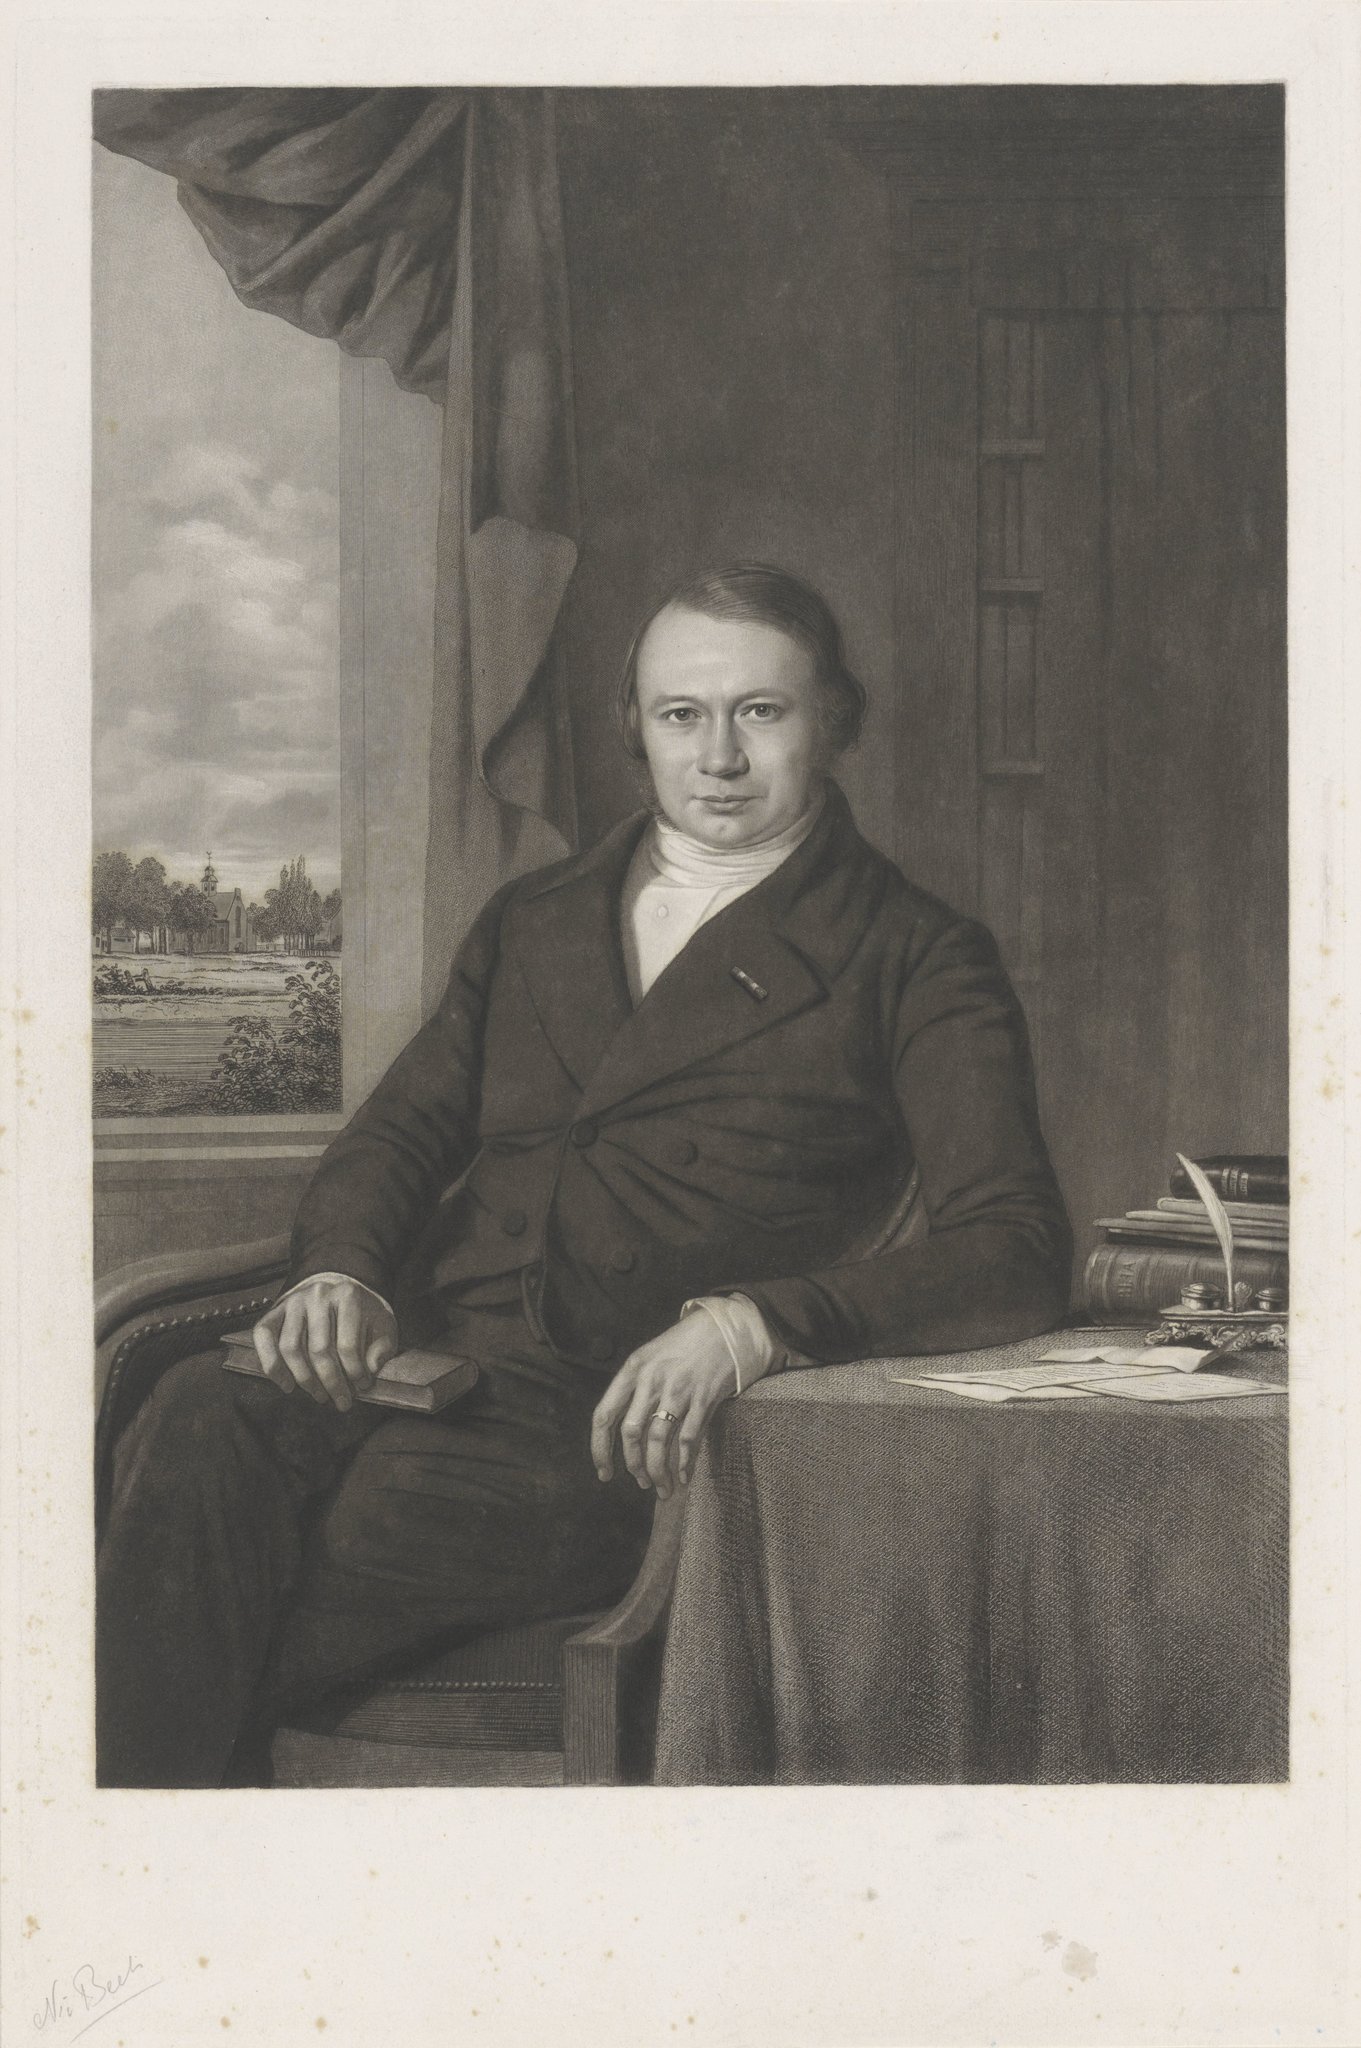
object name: print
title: Portret van Nicolaas Beets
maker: dirk jurriaan sluyter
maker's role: draughtsman, print maker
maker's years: 1811-1886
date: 1860-1879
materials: paper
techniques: etching, engraving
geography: amsterdam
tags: haarlem, utrecht, nicolaas beets, scholar in his study, portrait of a writer, writing accessories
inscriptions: collector's mark: Lugt 2228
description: Portret van Nicolaas Beets in de pastorie in Heemstede. Hij zit aan een tafel met schrijfbenodigdheden en boeken en houdt een boek in de hand. Achter hem een boekenkast met gordijn ervoor. Door het raam is de Hervormde Kerk te zien.